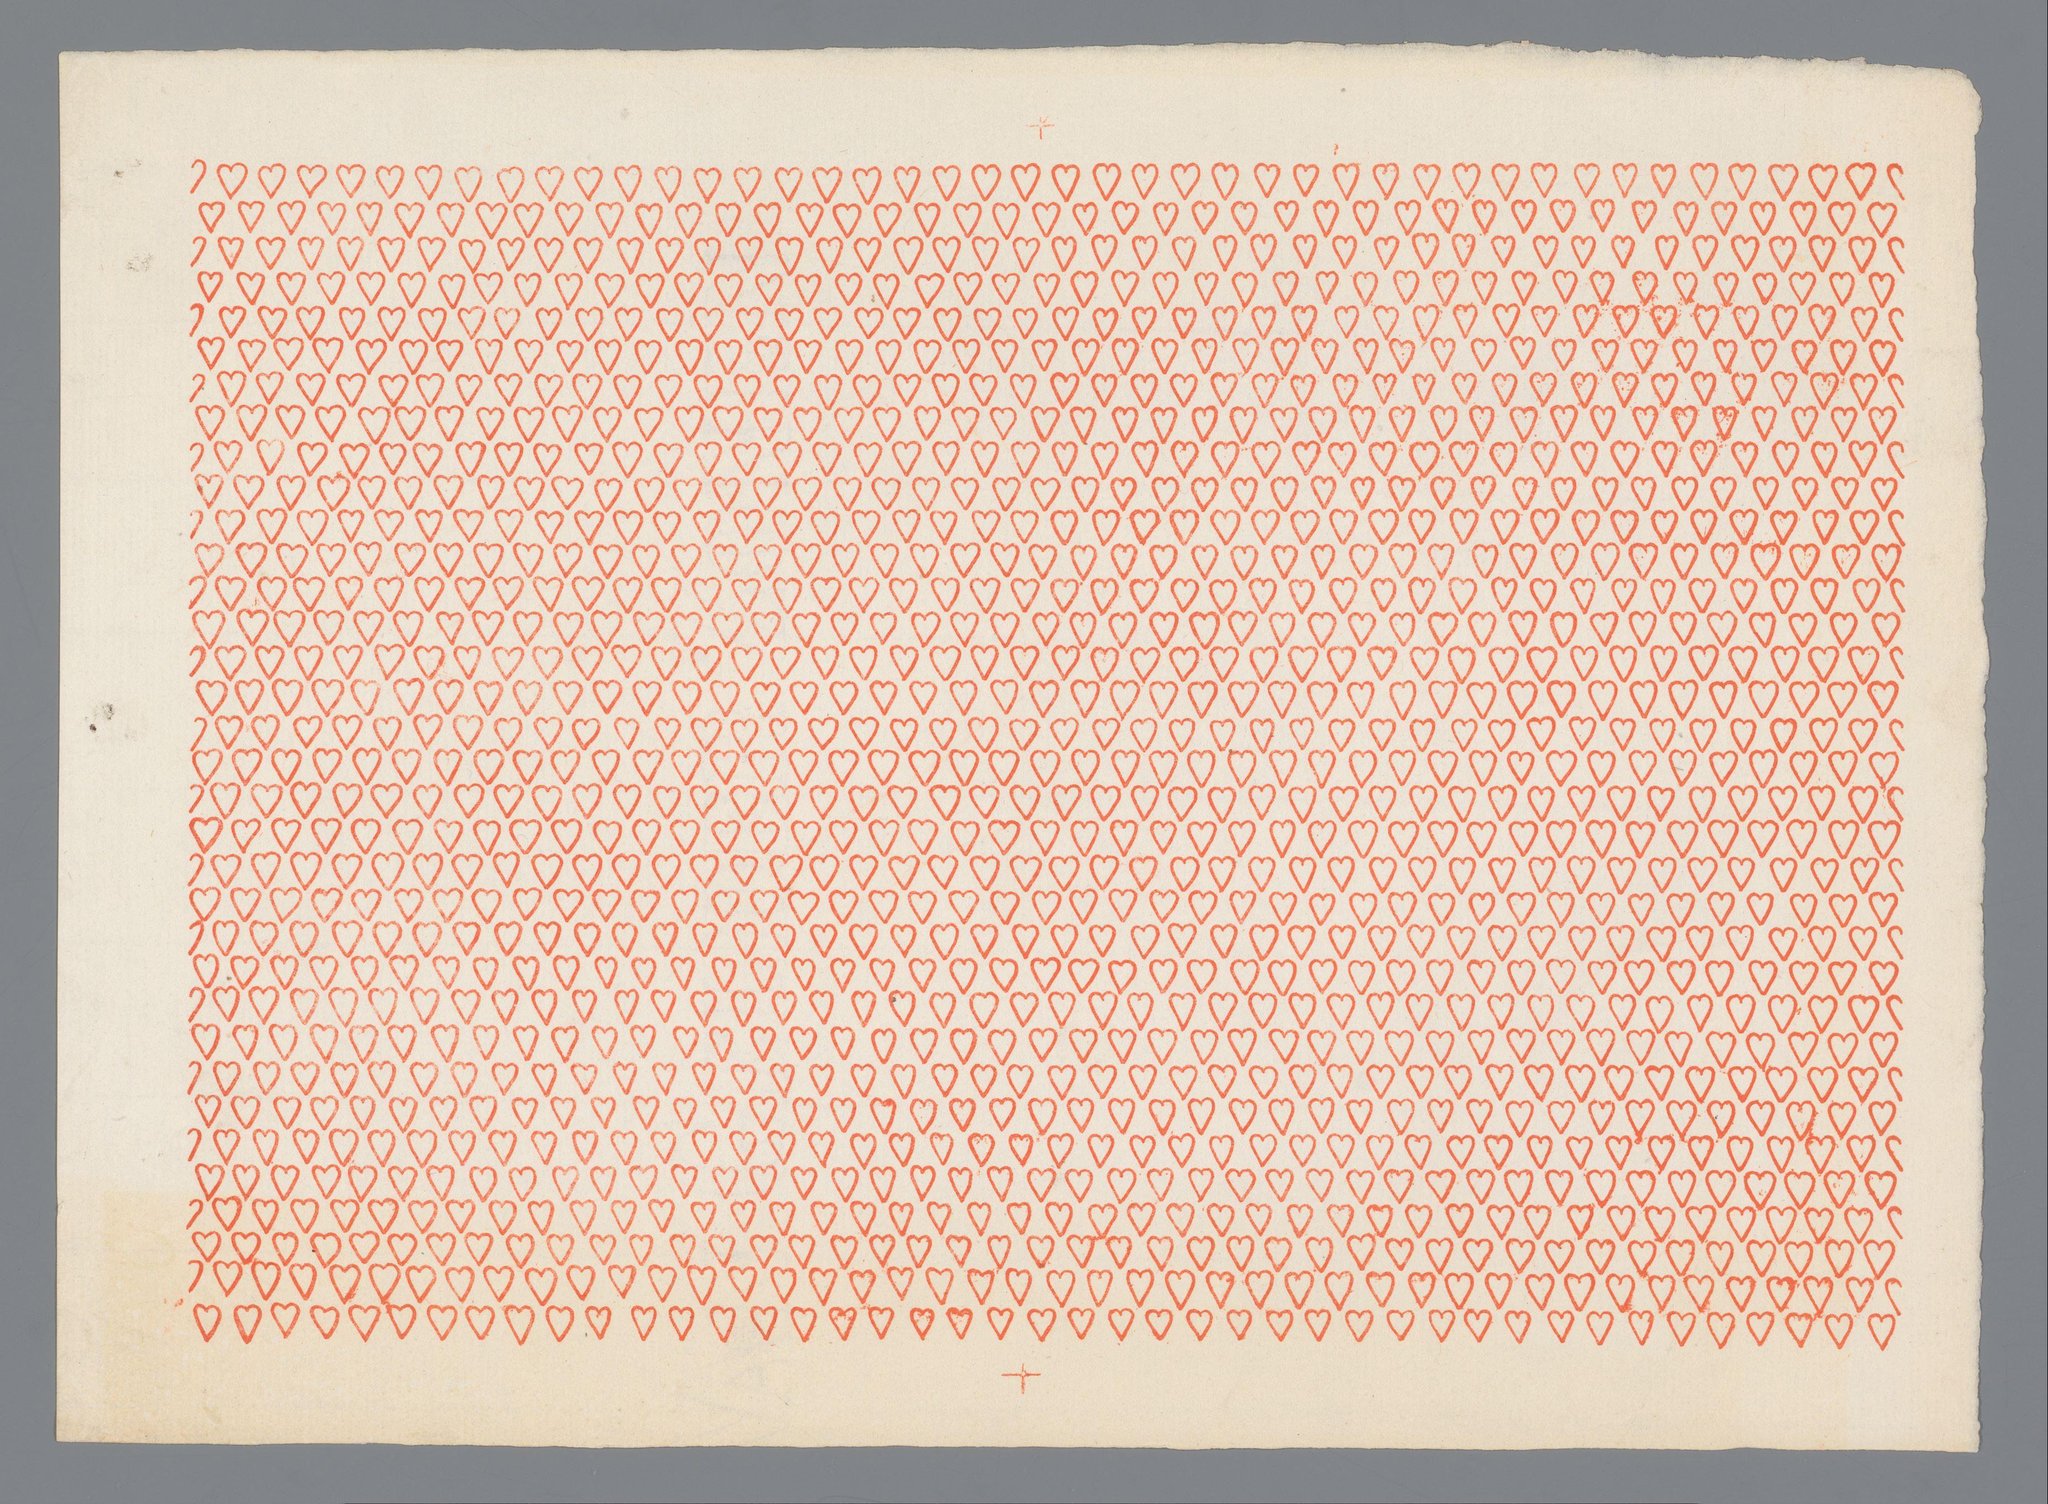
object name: printed paper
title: Blad met hartenpatroon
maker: Anonymous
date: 1900-1970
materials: paper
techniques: printing block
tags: ornament ~ human parts - aa - stylized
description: Blad met patroon met hartjes, gedrukt in rood.